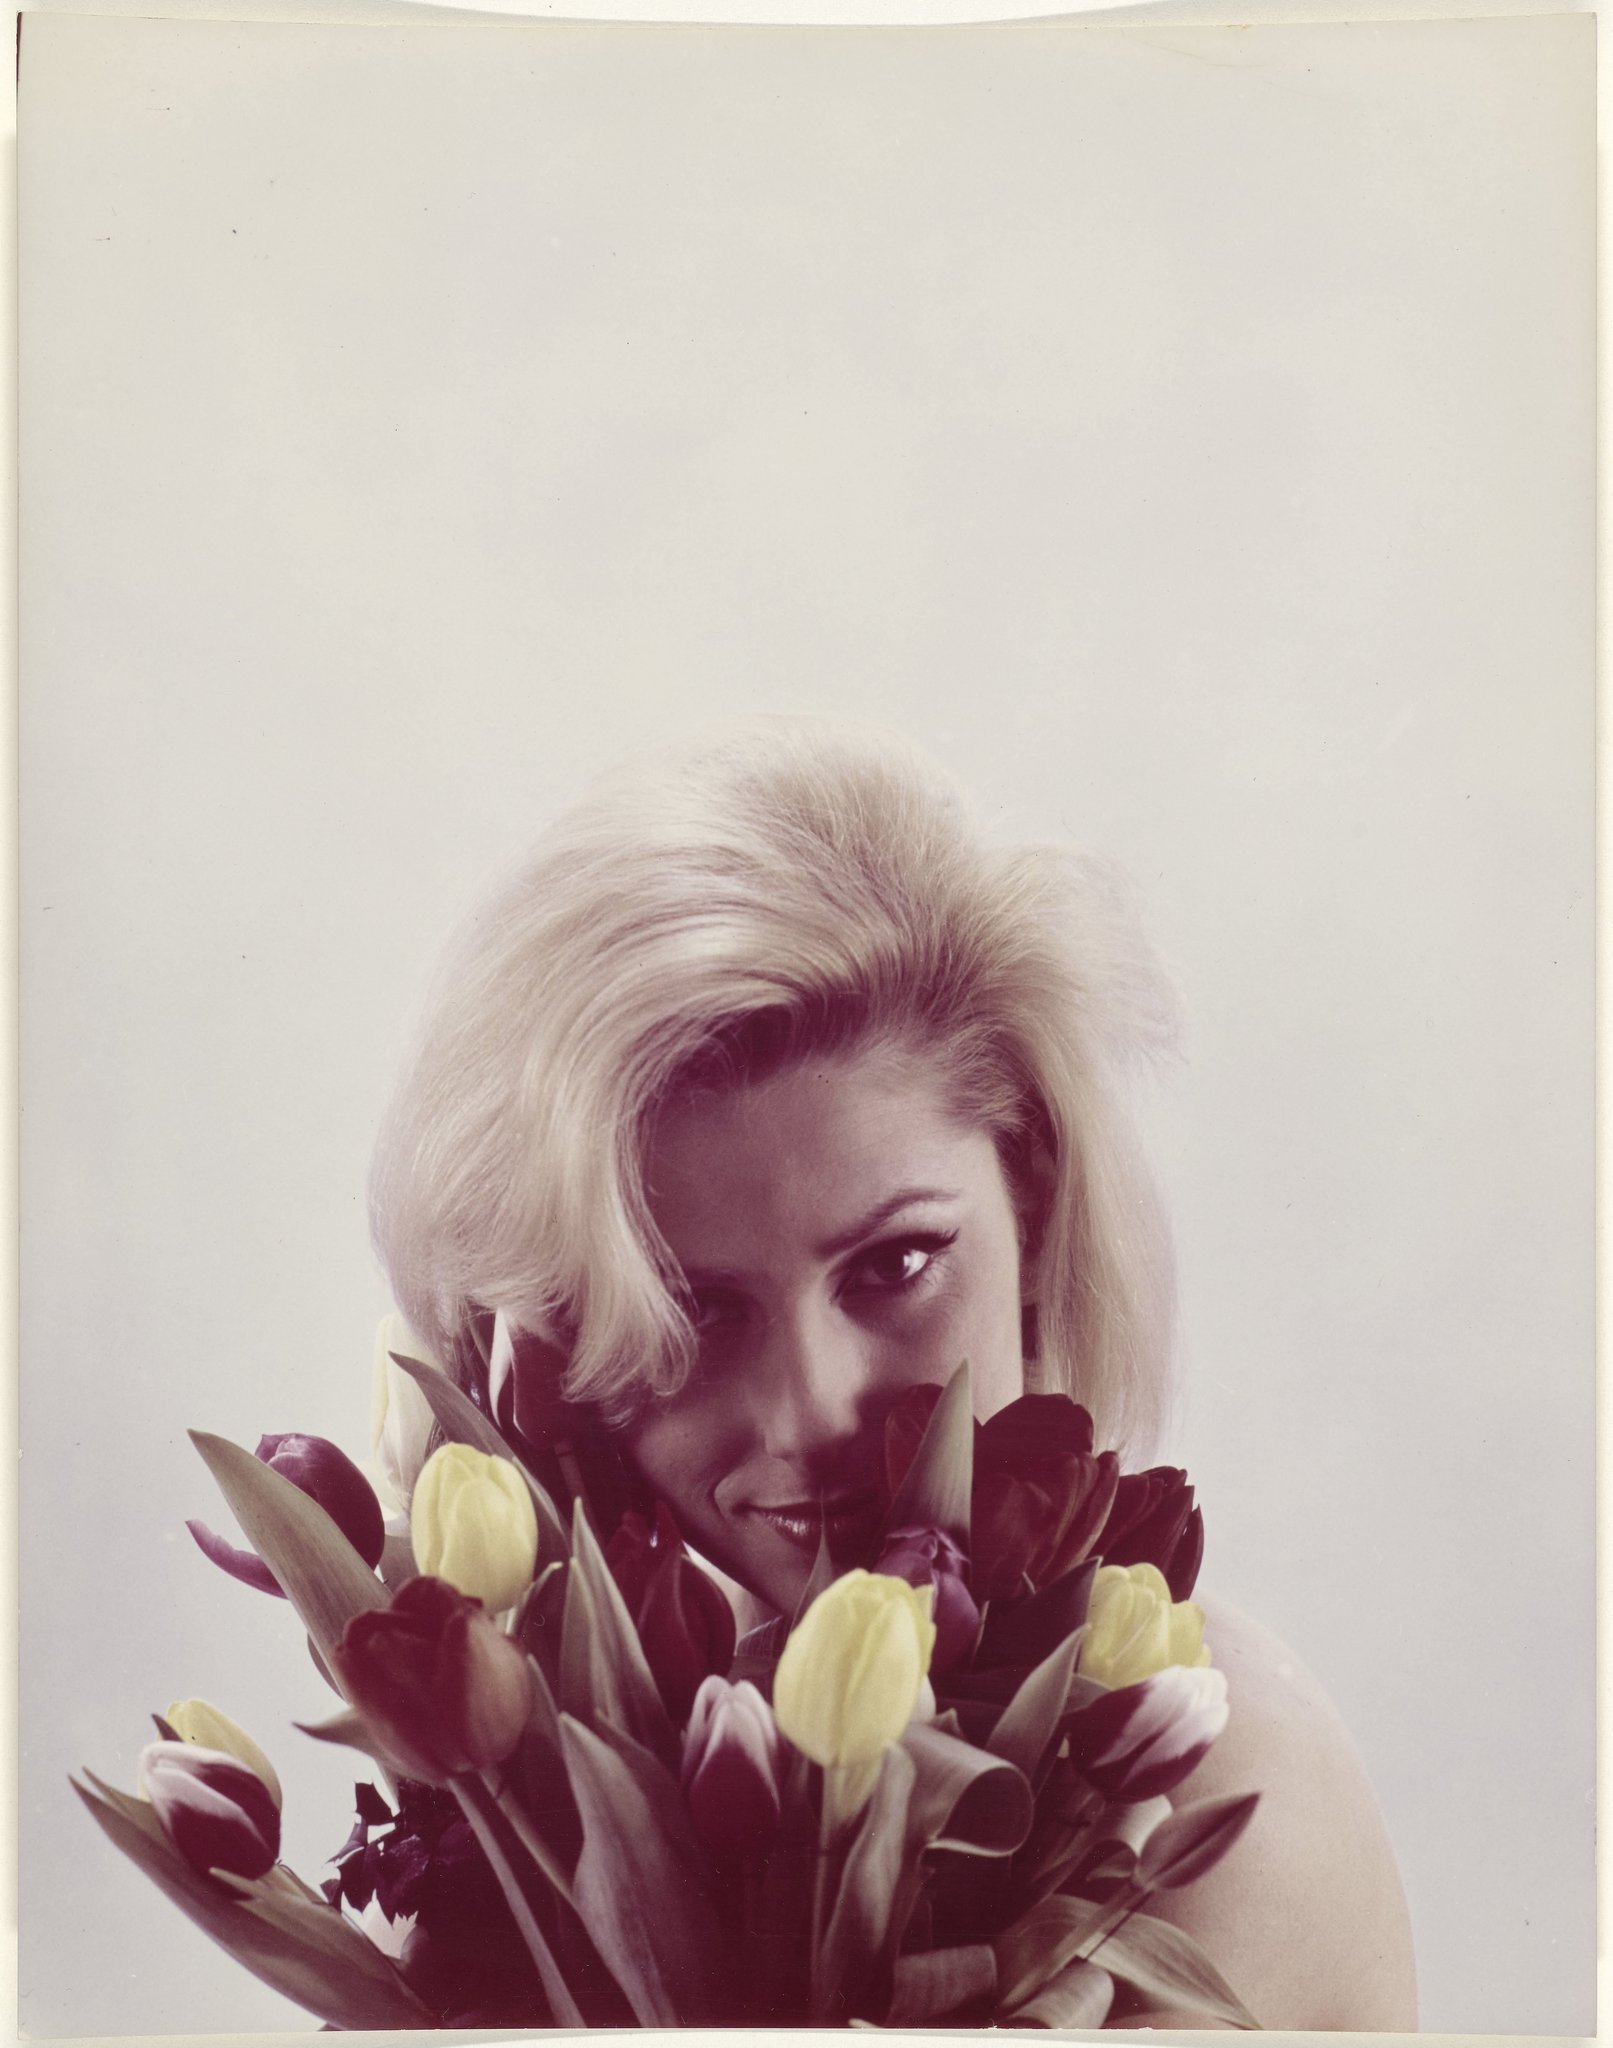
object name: photograph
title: Portret van een blondine met een bos tulpen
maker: j.f. van hengel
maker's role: fotograaf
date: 1965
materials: photographic support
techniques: chromogenic print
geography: netherlands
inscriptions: inscription: ‘Foto J.F. van Hengel 1965, verkocht aan Life’